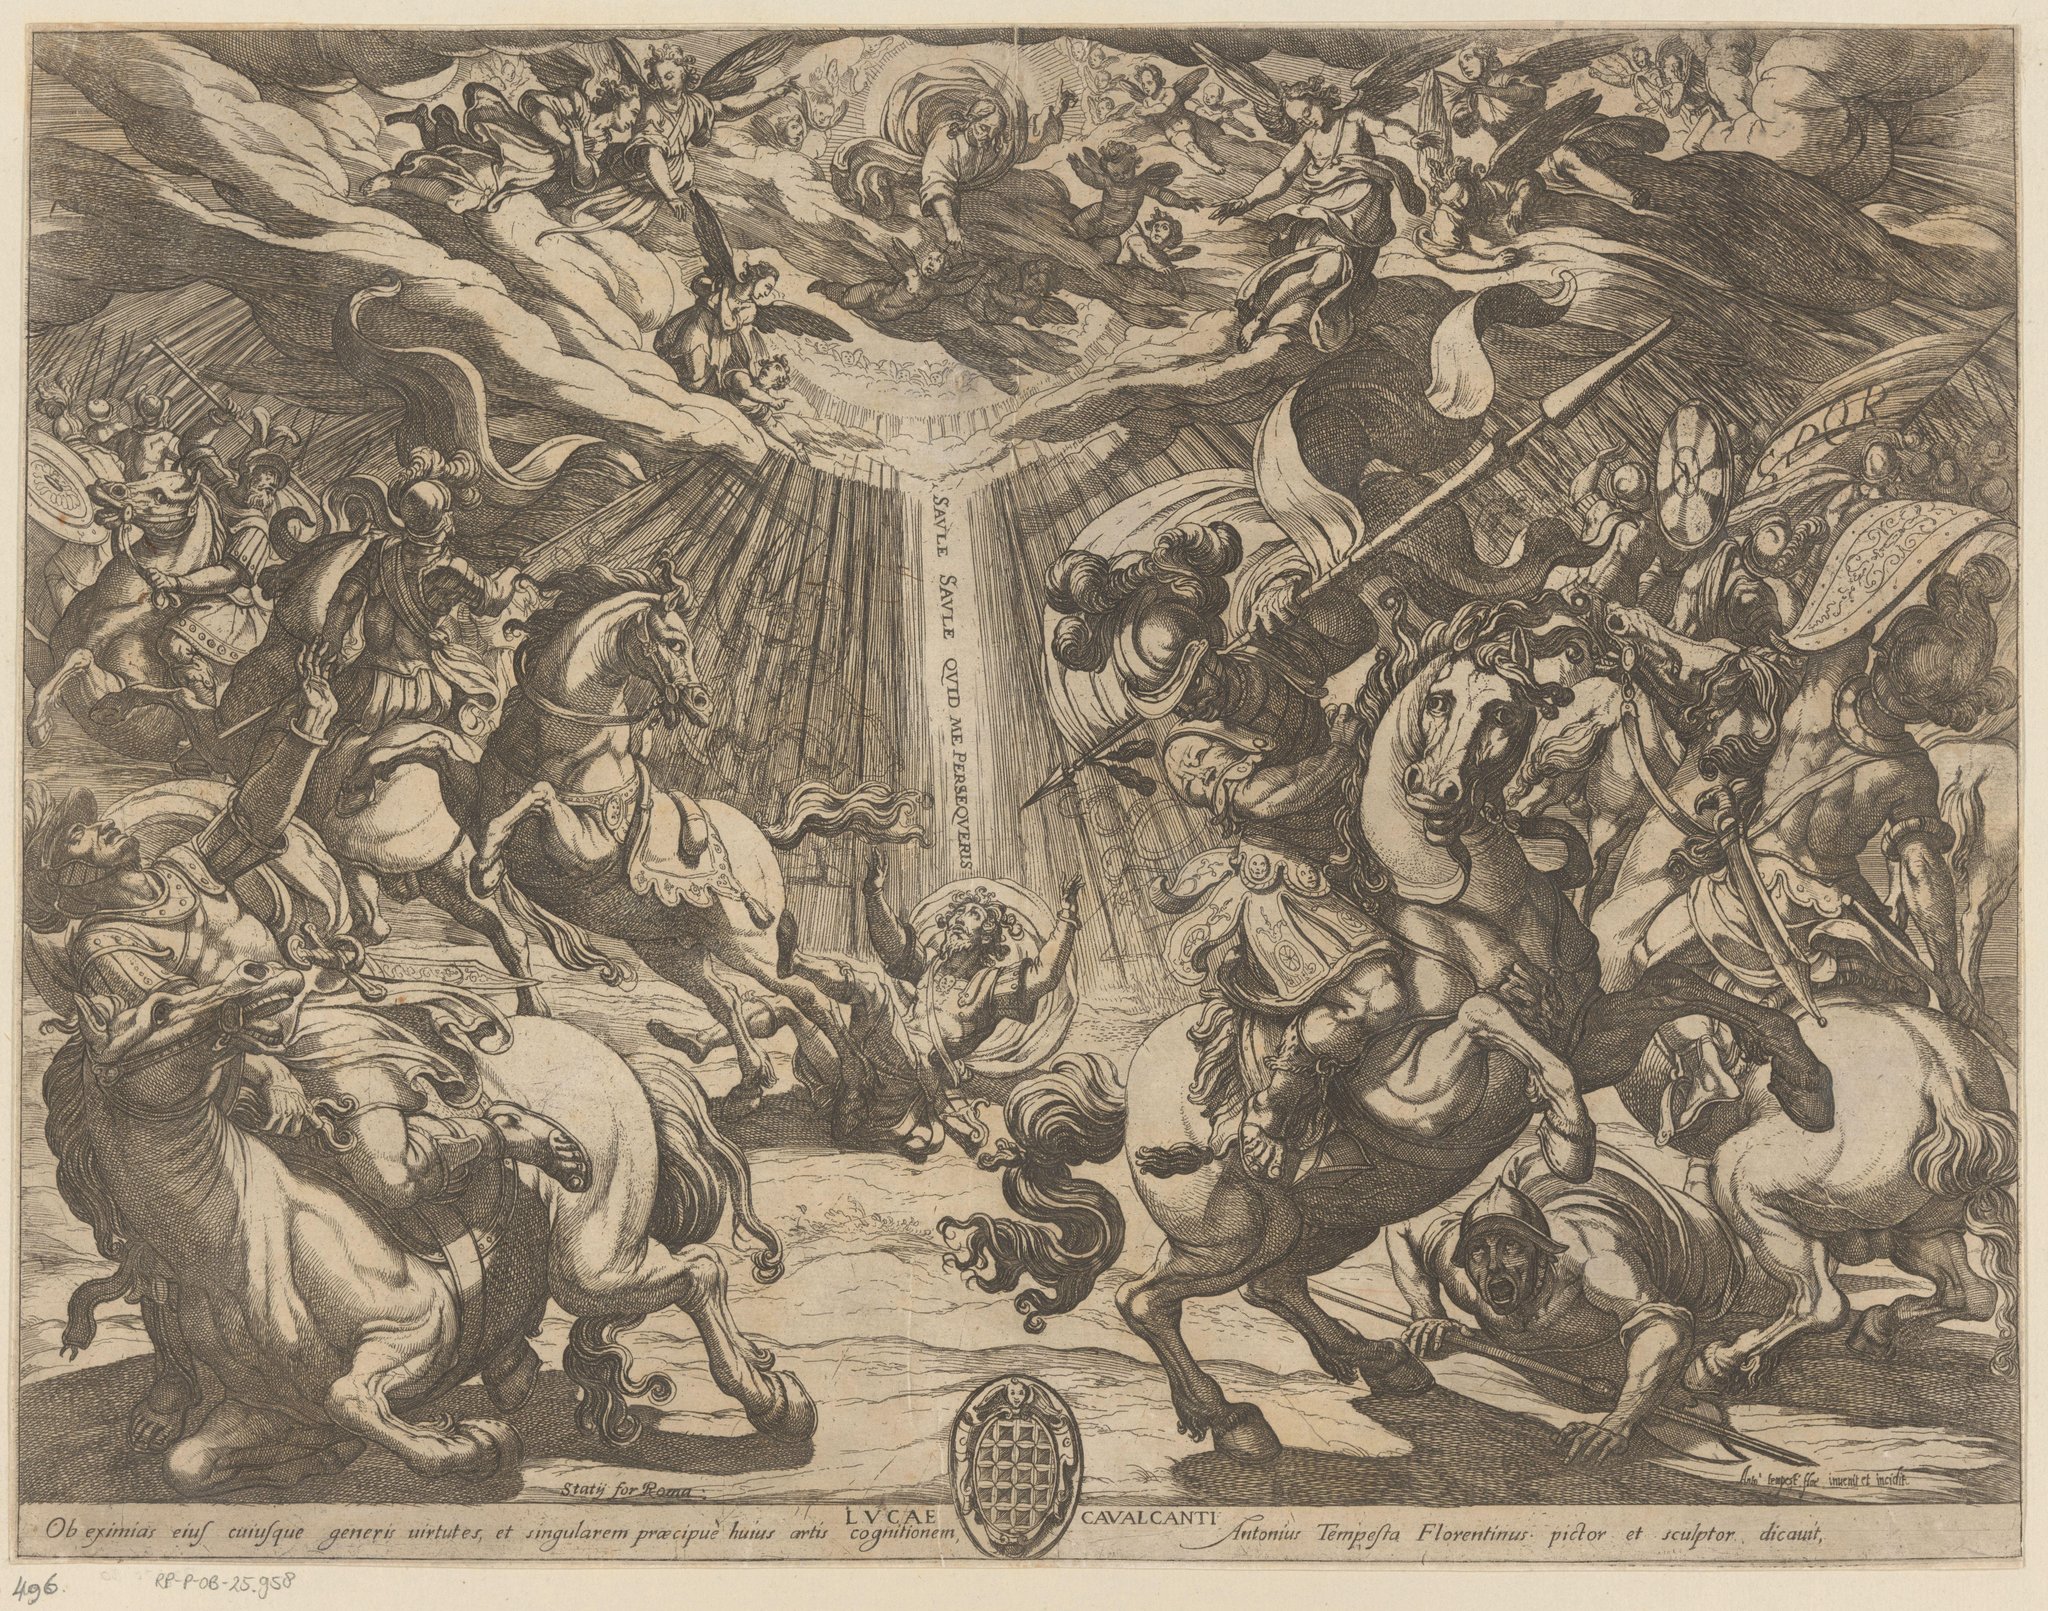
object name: print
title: De bekering van Paulus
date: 1565-1630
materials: paper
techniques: etching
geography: italy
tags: story of the conversion of paul (acts 9:1-18)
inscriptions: collector's mark: Lugt 240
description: Paulus (Saul) valt van zijn paard als God, omringd door een groep engelen, aan de hemel verschijnt en hem verblindt met een fel licht. Zijn soldaten zijn eveneens geschrokken en slaan op de vlucht.